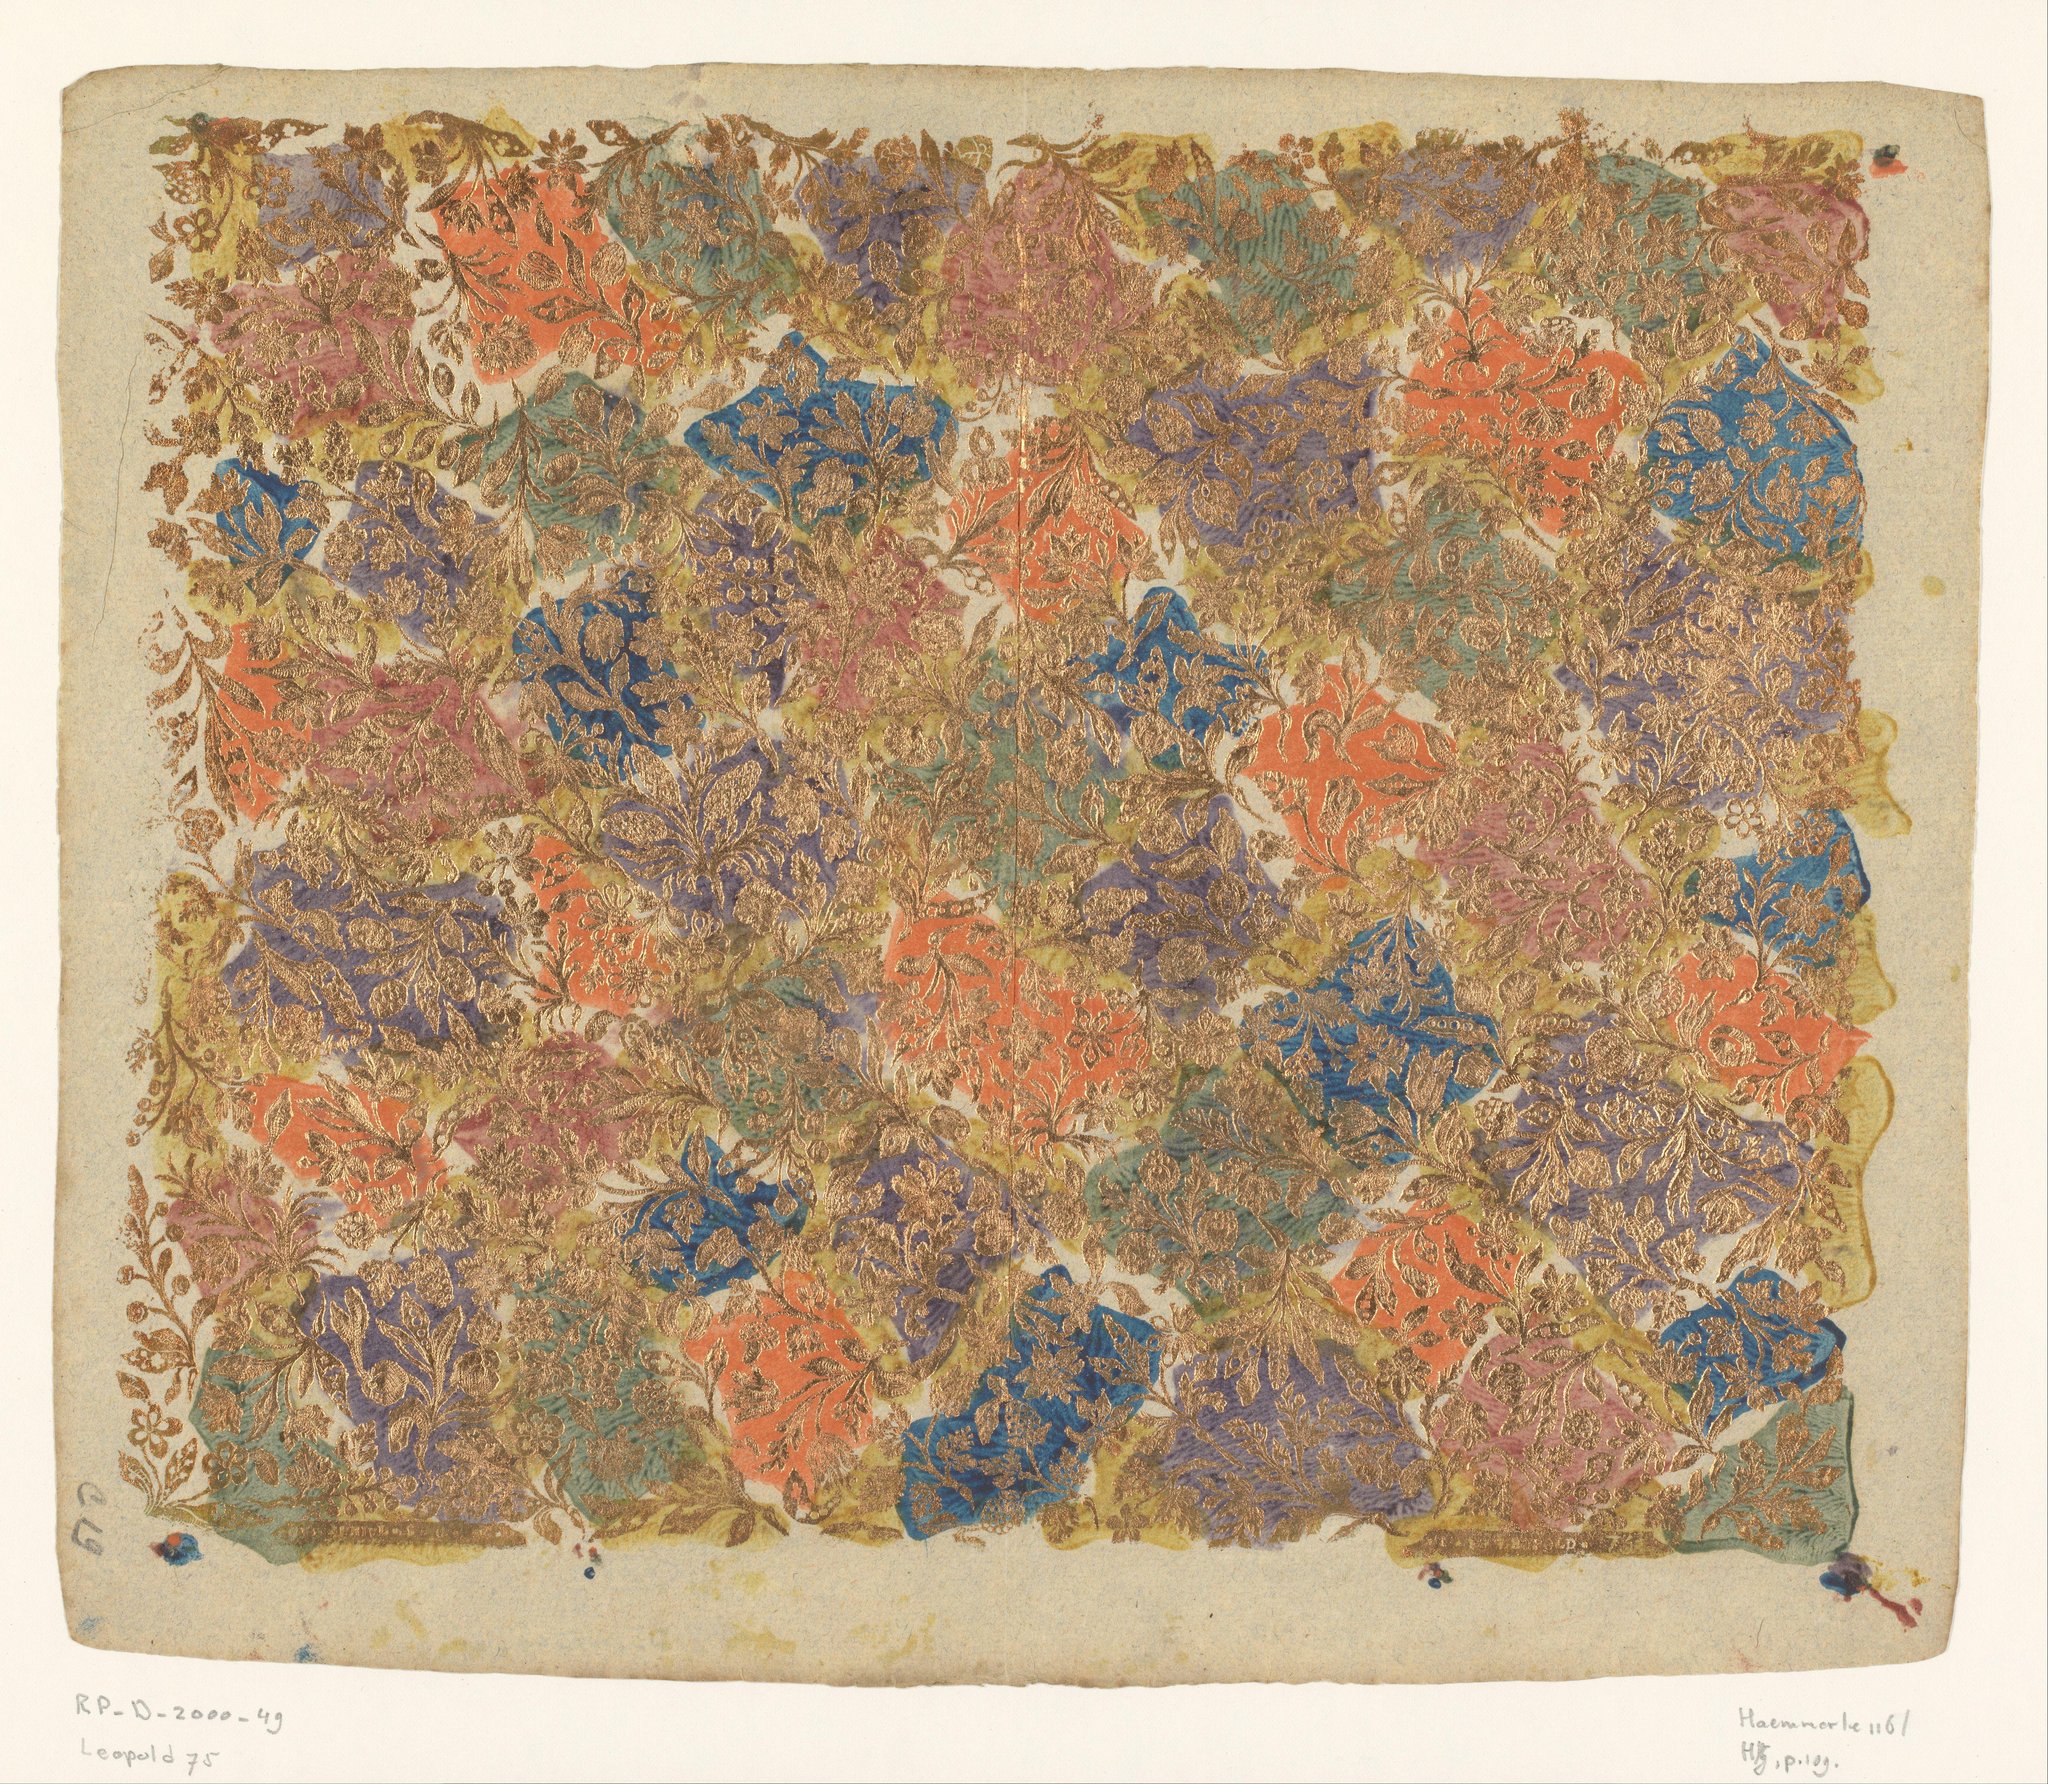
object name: brocade paper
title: Blad met kleine ranken met bloemen en vruchten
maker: joseph friedrich leopold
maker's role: print maker, publisher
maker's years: 1668-1726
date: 1669-1727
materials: gold leaf, paint, paper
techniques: relief print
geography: augsburg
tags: ornament derived from plant forms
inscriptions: collector's mark: Lugt 2760, collector's mark: Lugt 2228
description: Blad met kleine ranken met bloemen en vruchten, dicht op elkaar staand. Genummerd onderaan: 75.